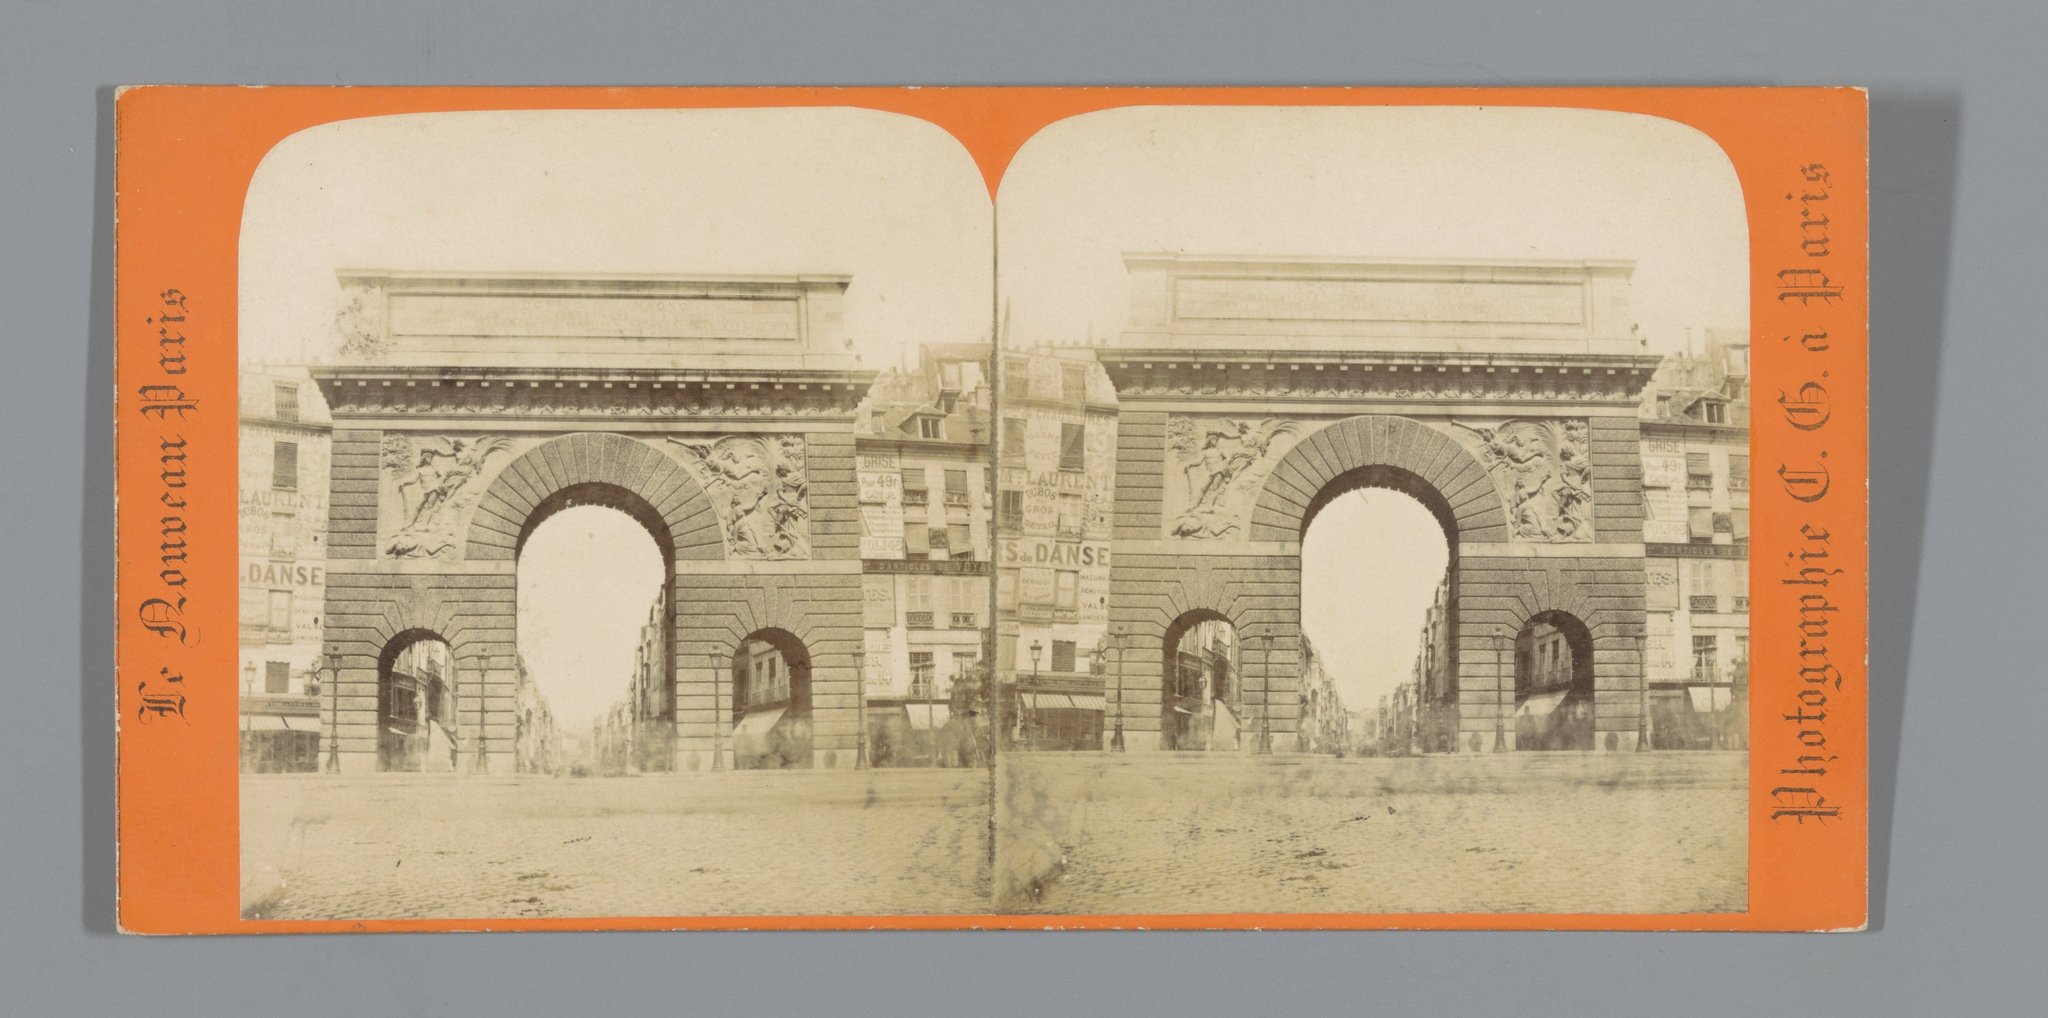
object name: stereograph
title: Gezicht op de Porte Saint-Martin te Parijs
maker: charles gérard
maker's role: fotograaf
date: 1860-1870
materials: cardboard, photographic support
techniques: albumen print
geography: paris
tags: triumphal arch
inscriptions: inscription: ‘Photographie C. G. à Paris.’, inscription: ‘Porte St Martin’